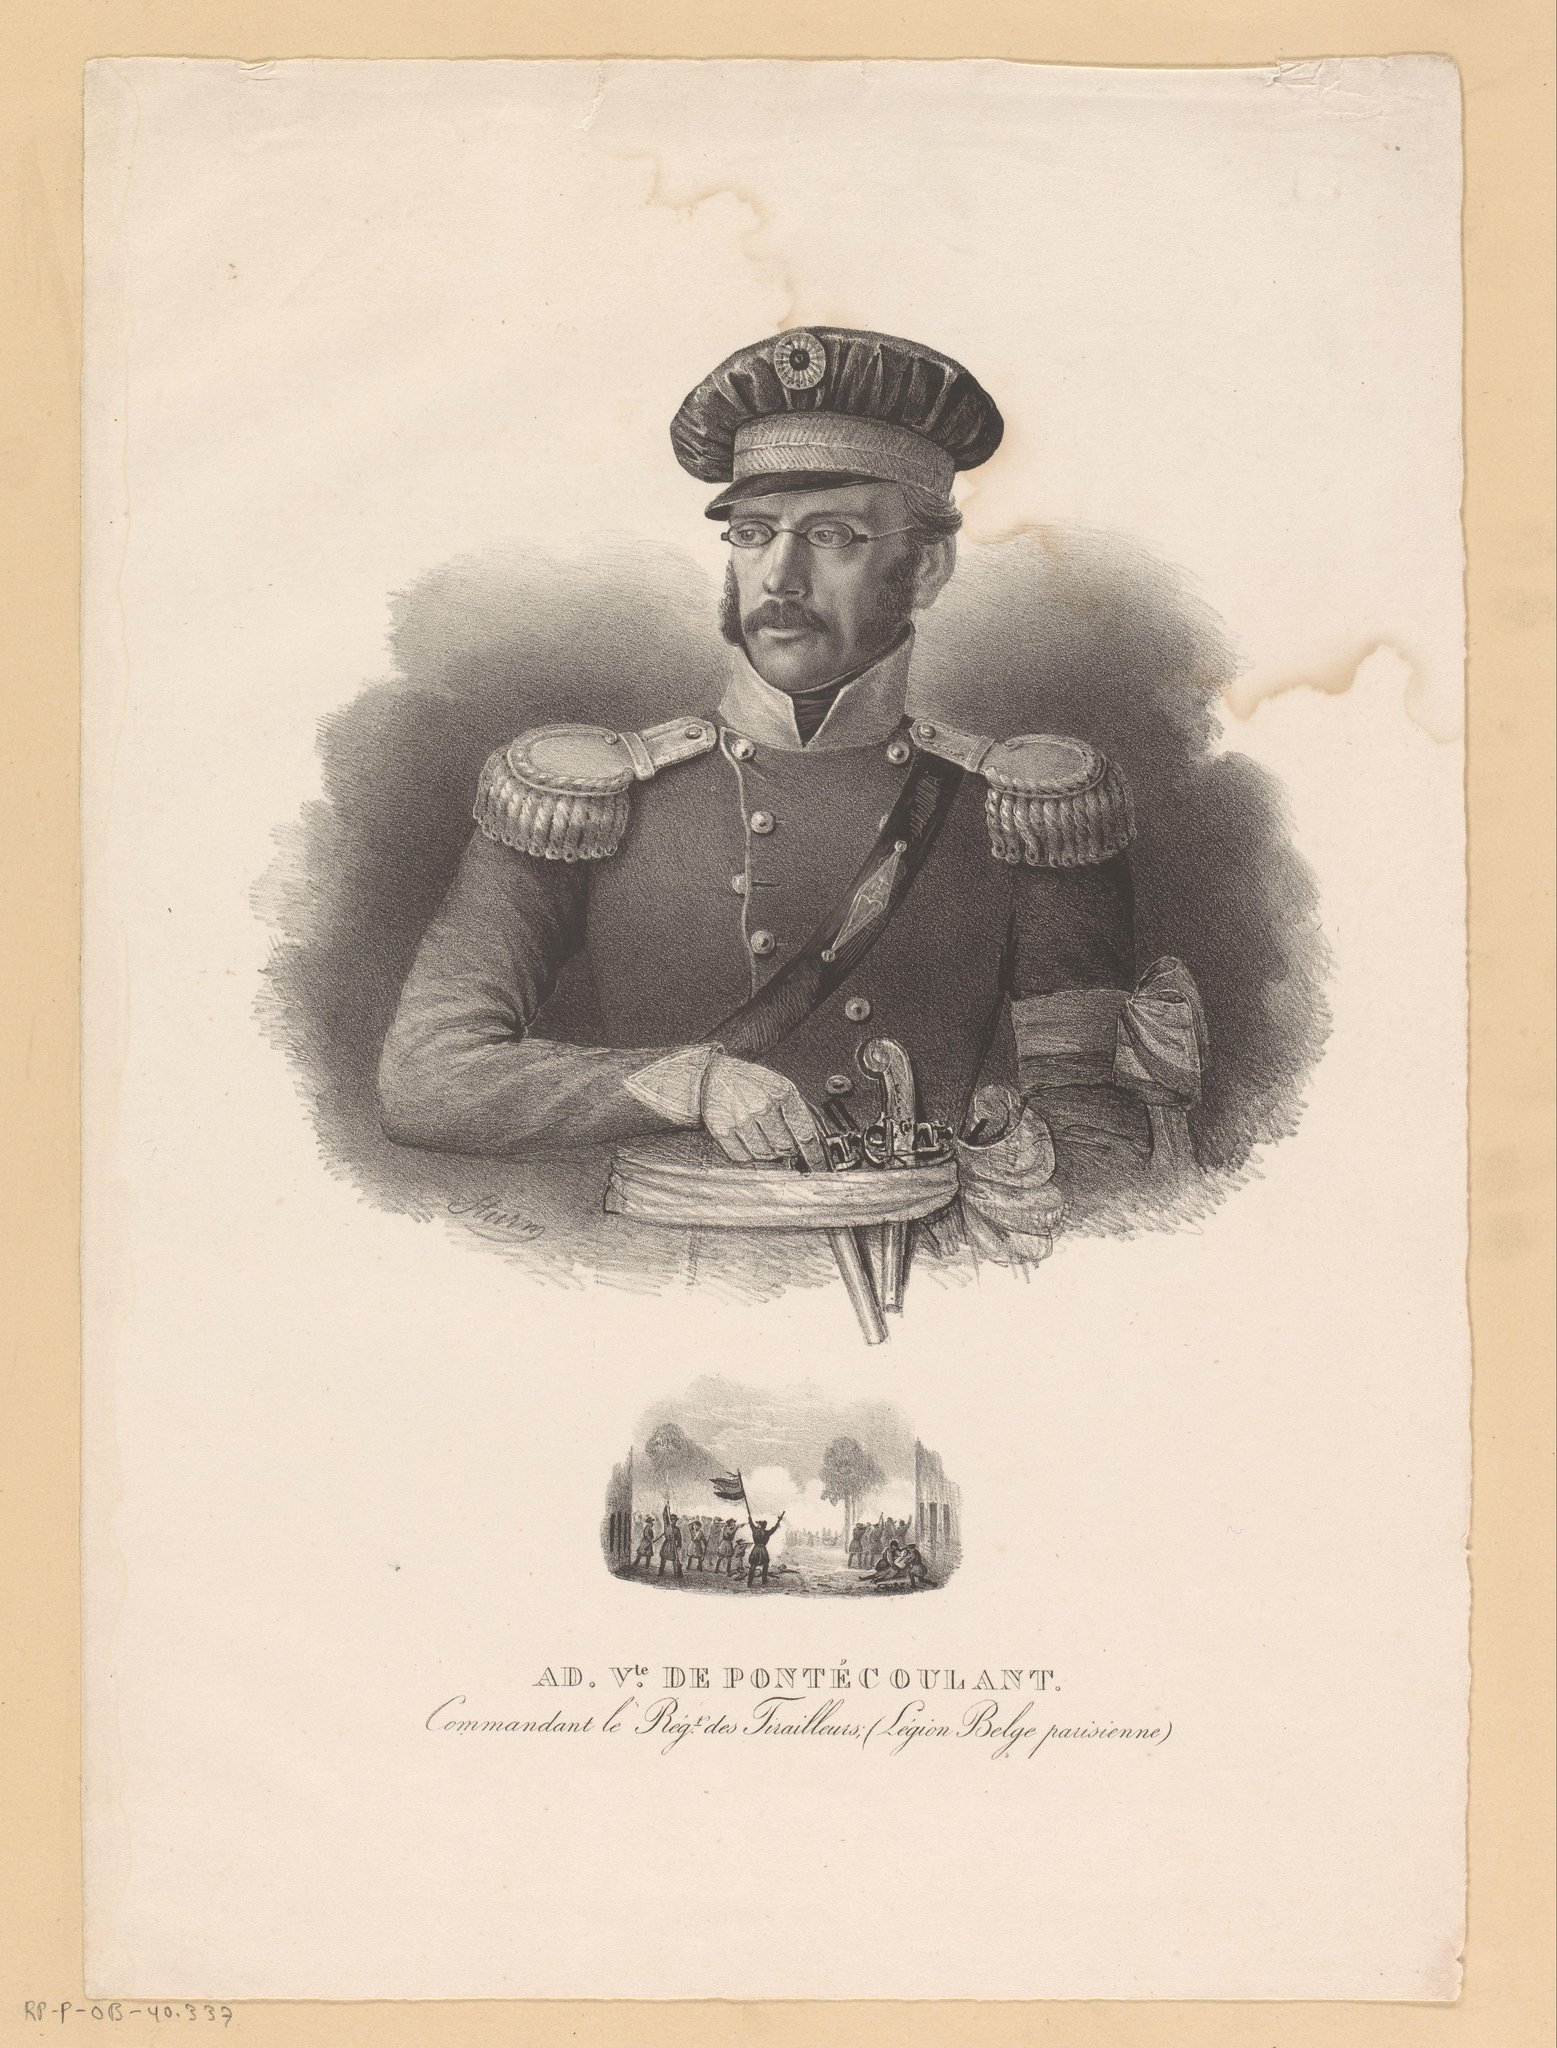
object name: print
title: Portret van Louis-Adolph Le Doulcet, Comte de Pontécoulant, 1830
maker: jacques sturm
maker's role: print maker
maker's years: 1807-1844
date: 1830-1835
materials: paper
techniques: lithograph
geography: belgium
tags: louis-adolphe de pontécoulant, belgische revolutie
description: Portret van Adolphe de Pontécoulant, bevelhebber van het Frans-Belgisch legioen tirailleurs, 1830. Met twee pistolen in de ceintuur om de middel gestoken. Onderaan een kleine voorstelling van straatgevechten. Onderdeel van een groep portretten van personen die aan de Belgische Revolutie hebben deelgenomen of daardoor vermaard zijn.